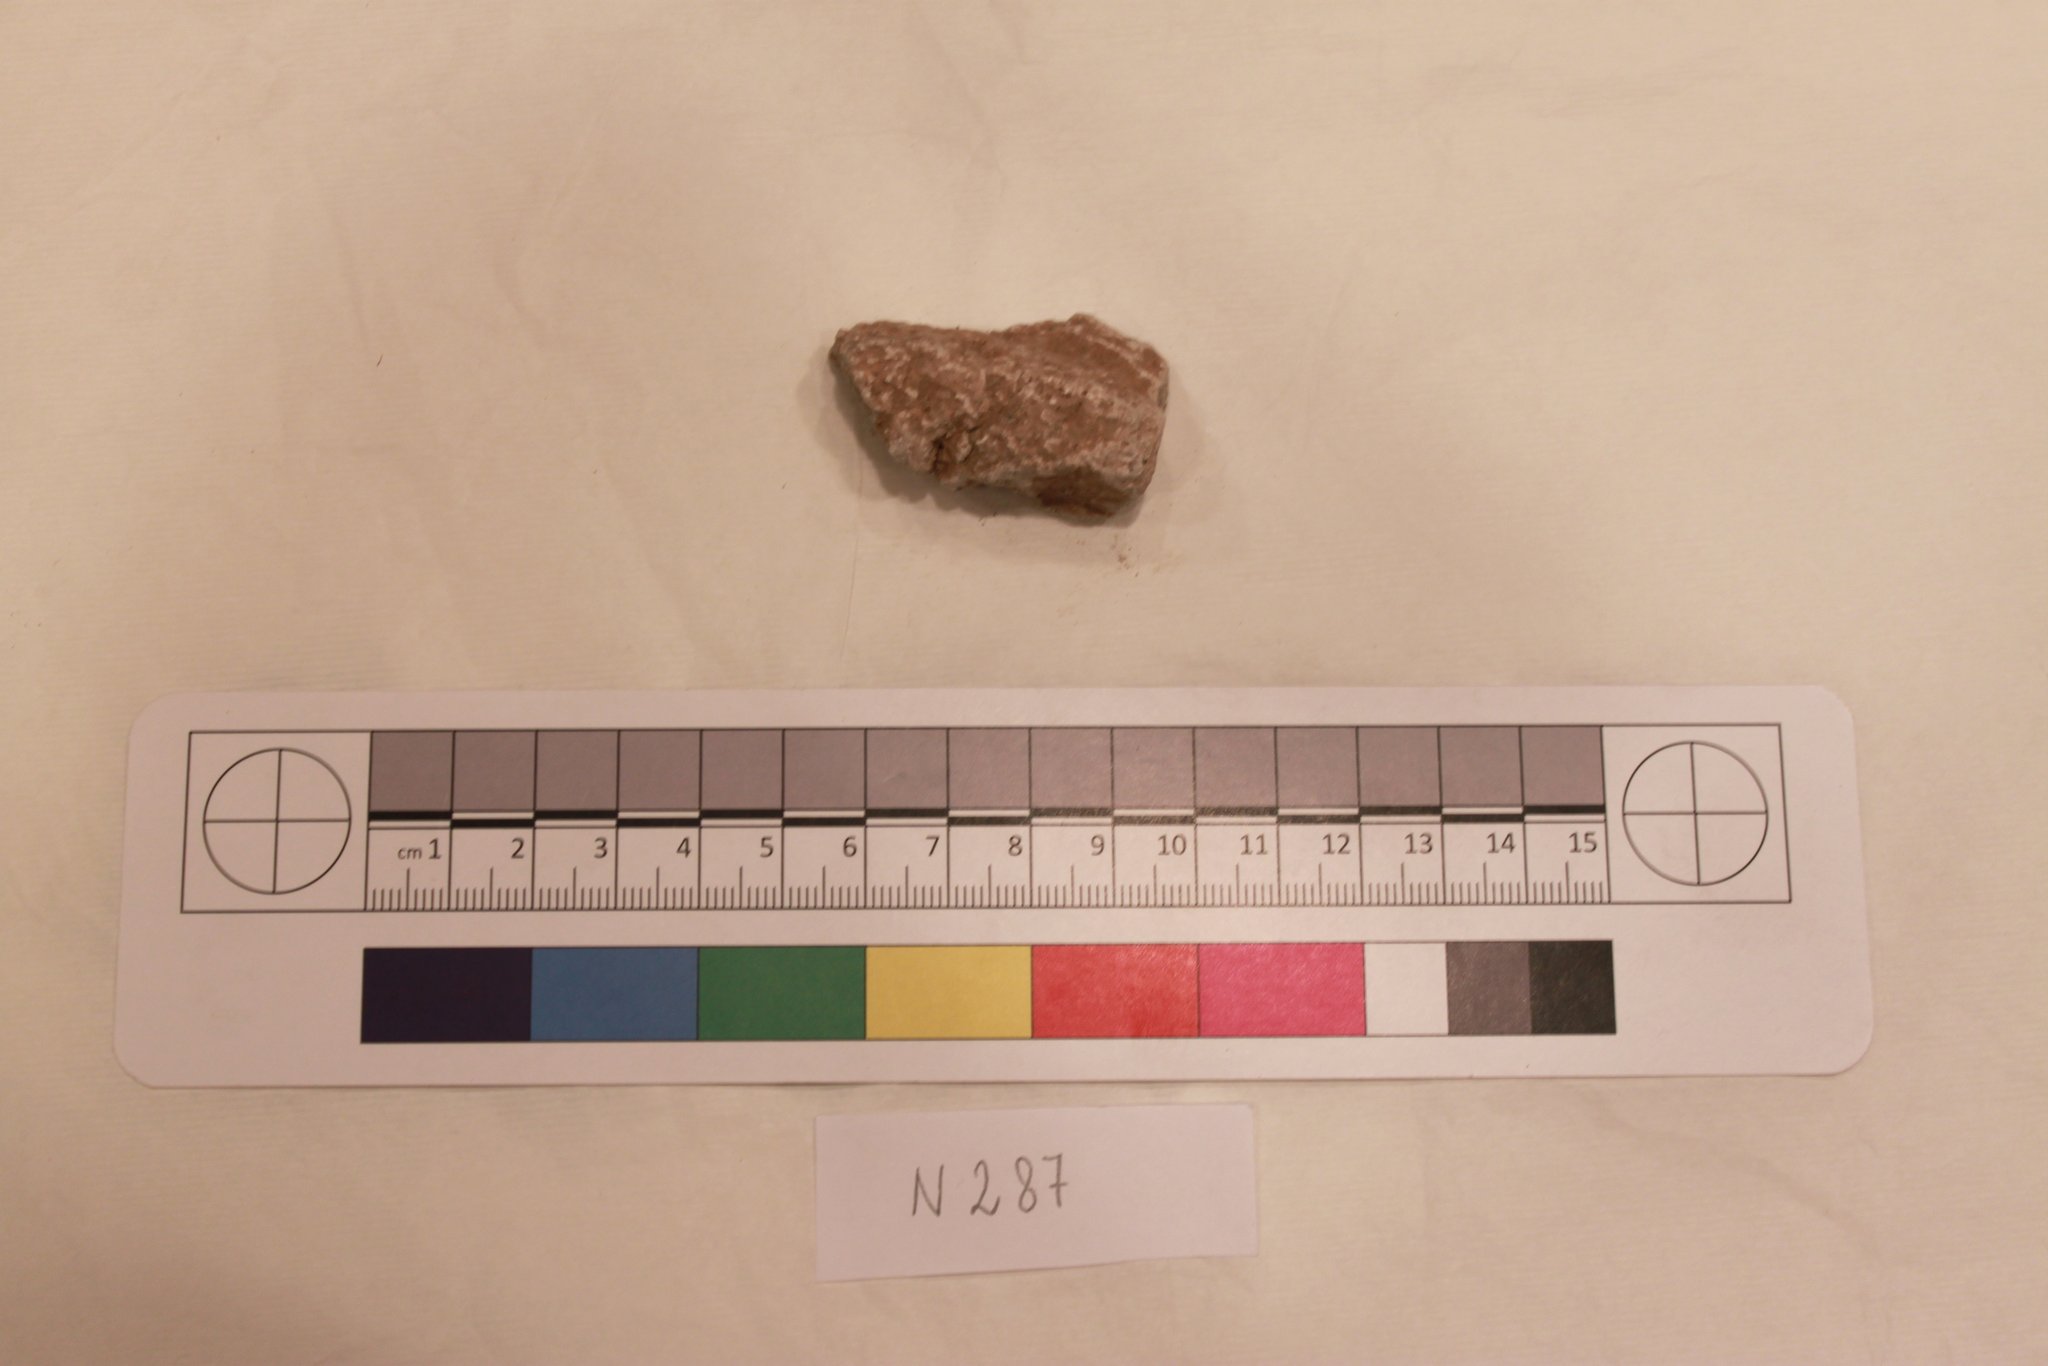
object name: fragment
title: Stucco Fragment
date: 701-1200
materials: plaster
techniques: carving, painting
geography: iran